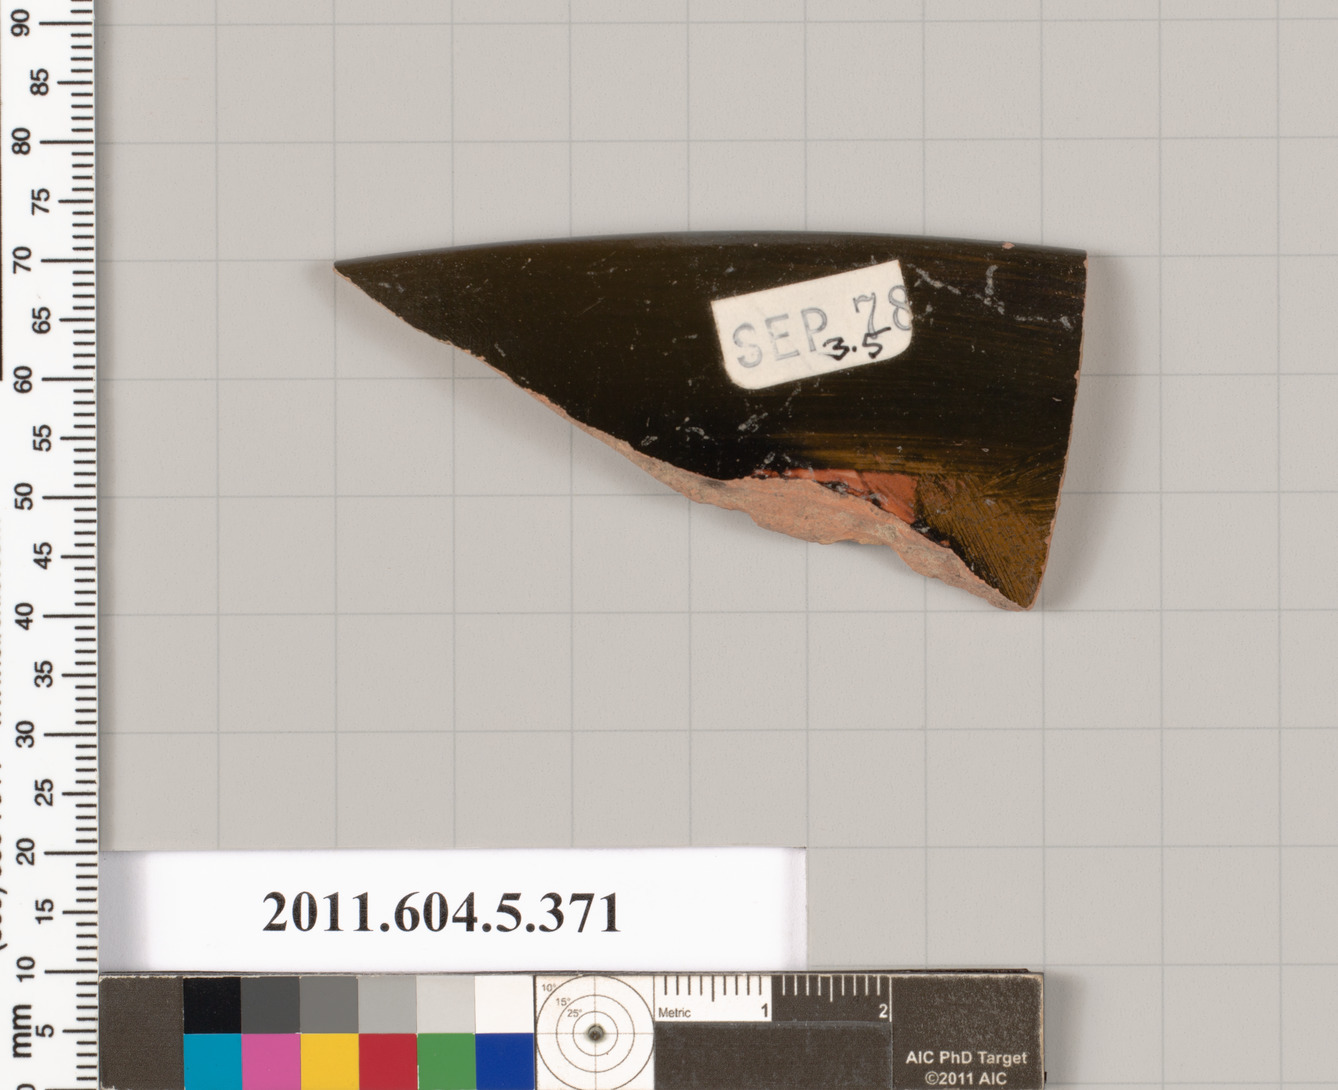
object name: kylix fragment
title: Terracotta rim fragment of a kylix (drinking cup)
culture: greek, attic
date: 600-401 BCE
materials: terracotta